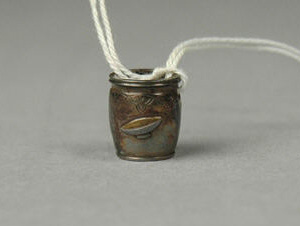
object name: ojime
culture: japanese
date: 1801-1900